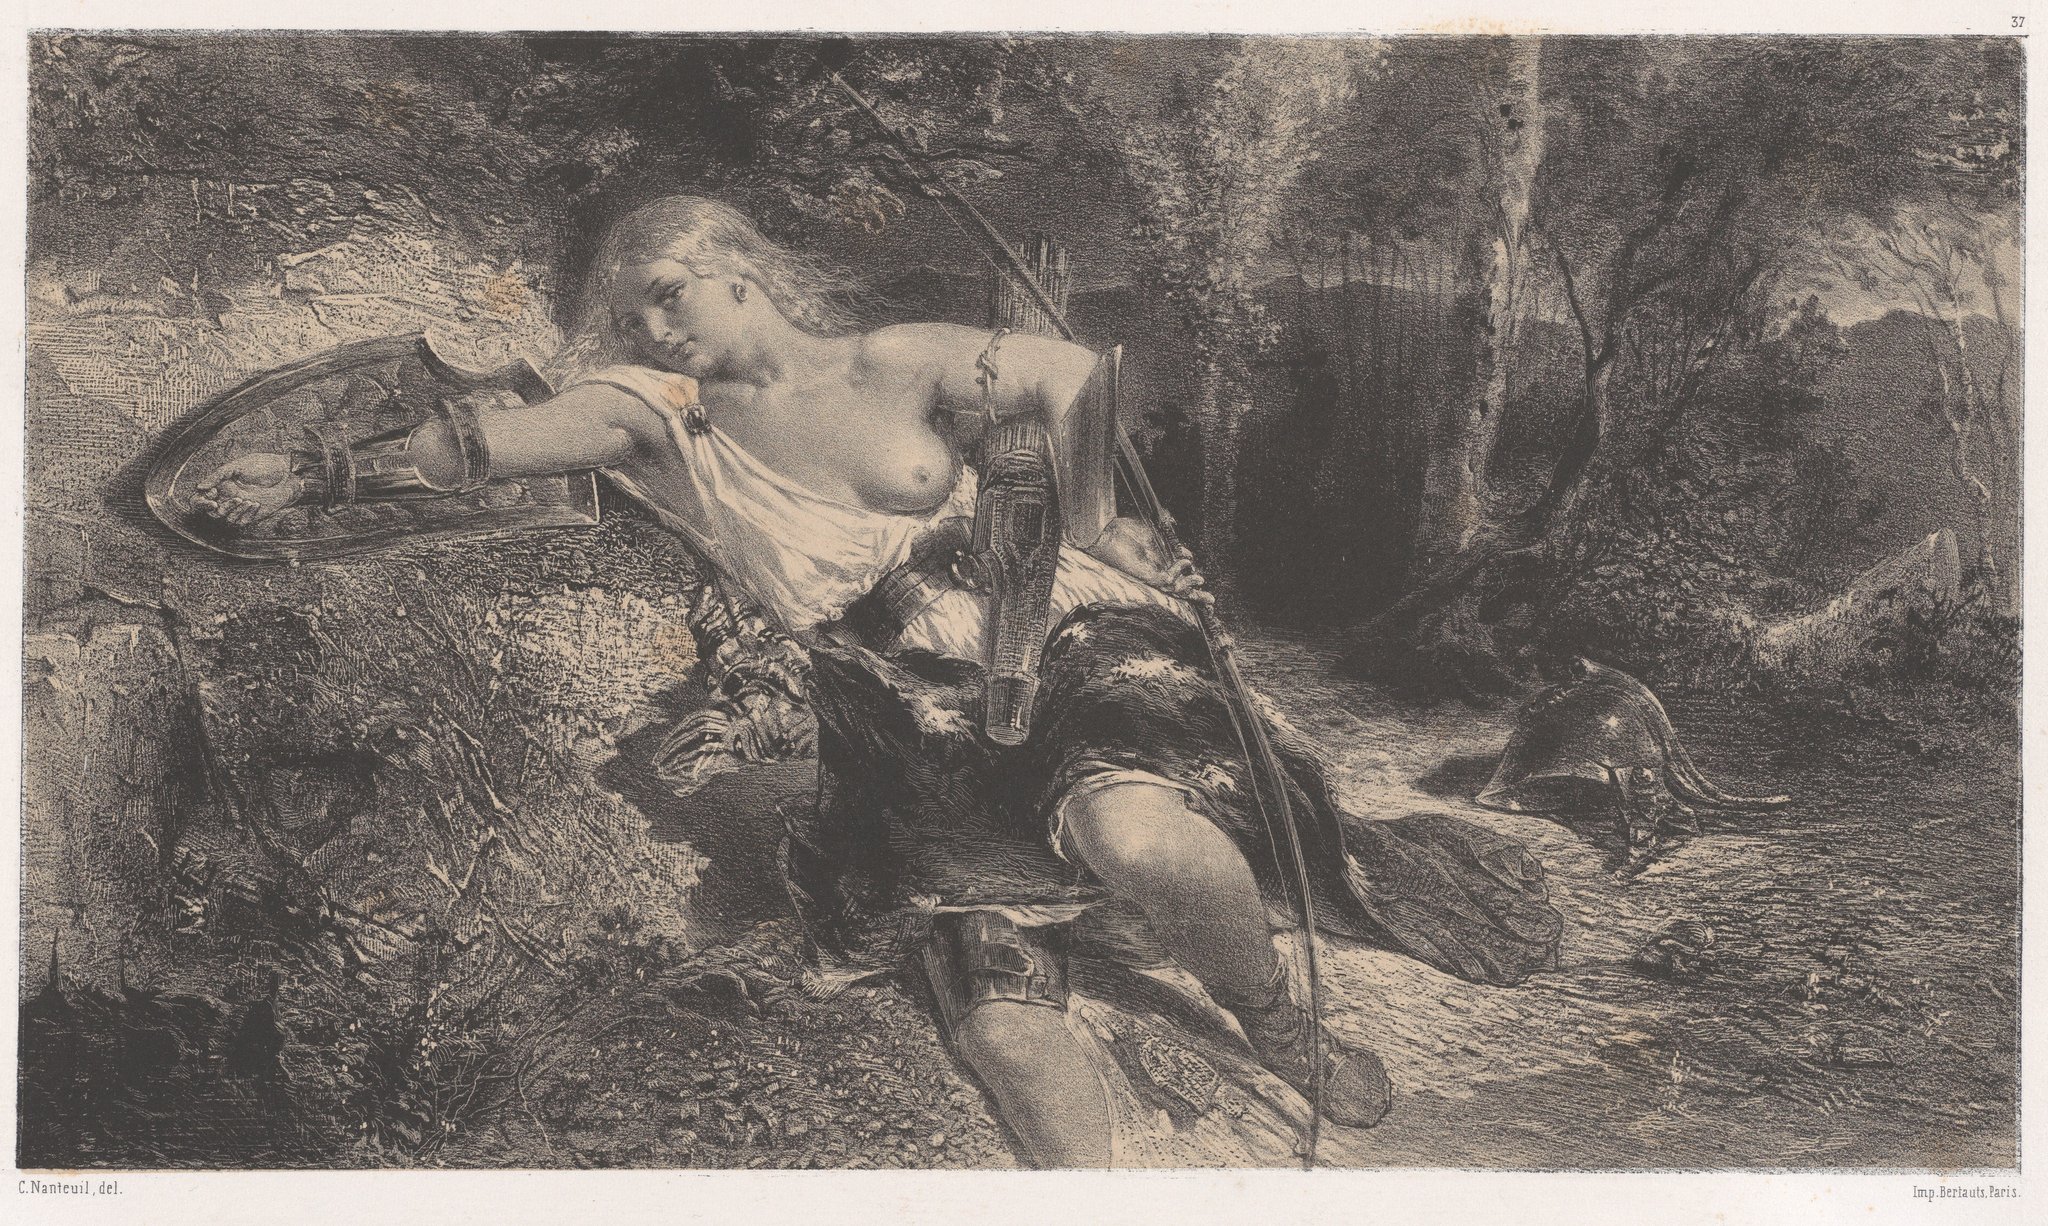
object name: print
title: Clorinde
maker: célestin nanteuil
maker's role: artist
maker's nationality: french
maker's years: 1813-1873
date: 1847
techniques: lithograph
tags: bow and arrow,female nudes